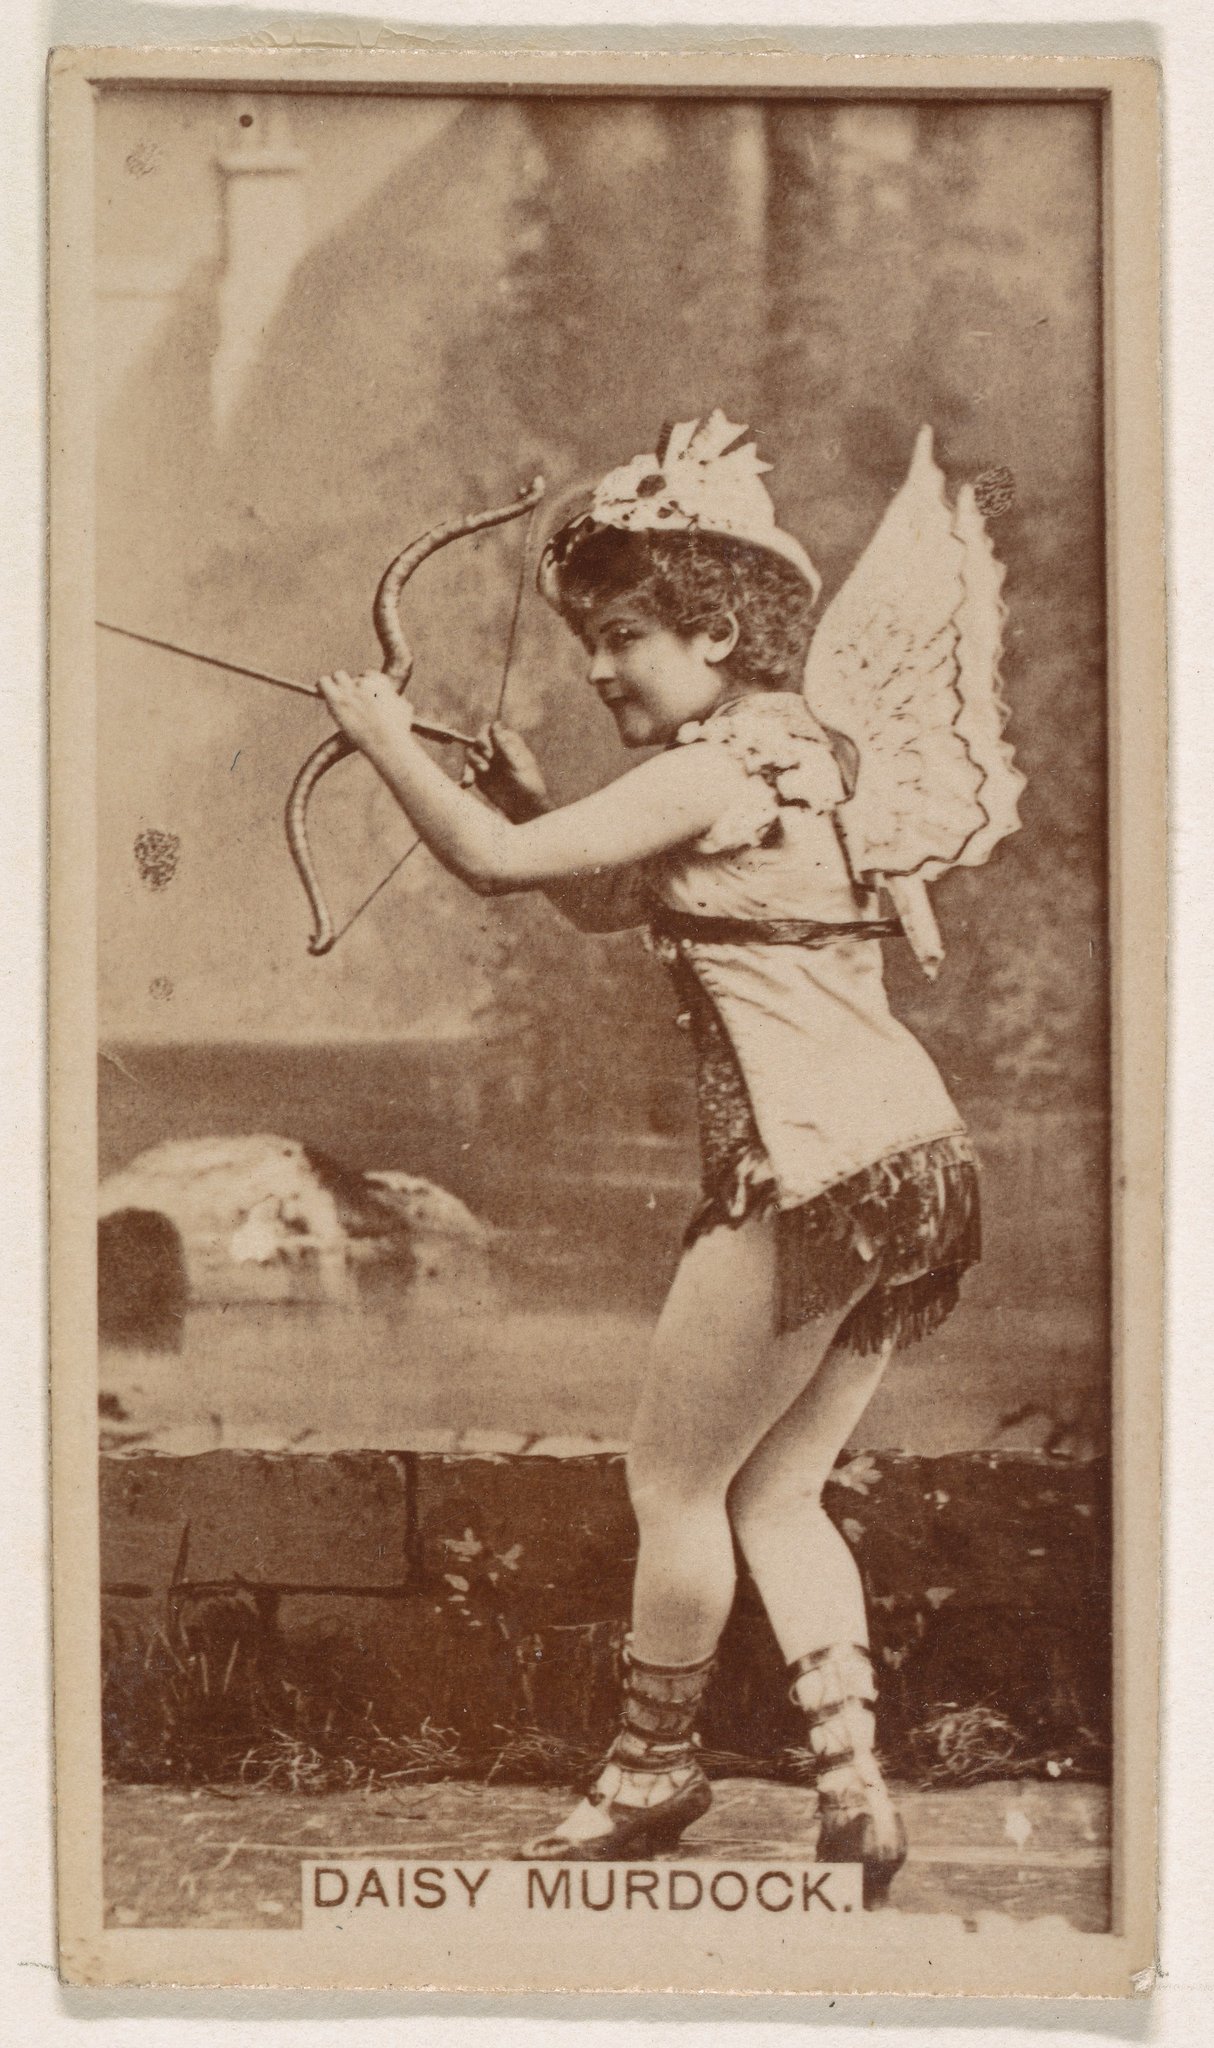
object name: photograph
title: Daisy Murdoch, from the Actresses series (N245) issued by Kinney Brothers to promote Sweet Caporal Cigarettes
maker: kinney brothers tobacco company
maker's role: publisher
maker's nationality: american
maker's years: 1869-2011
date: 1890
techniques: albumen silver print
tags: portraits,women,actresses